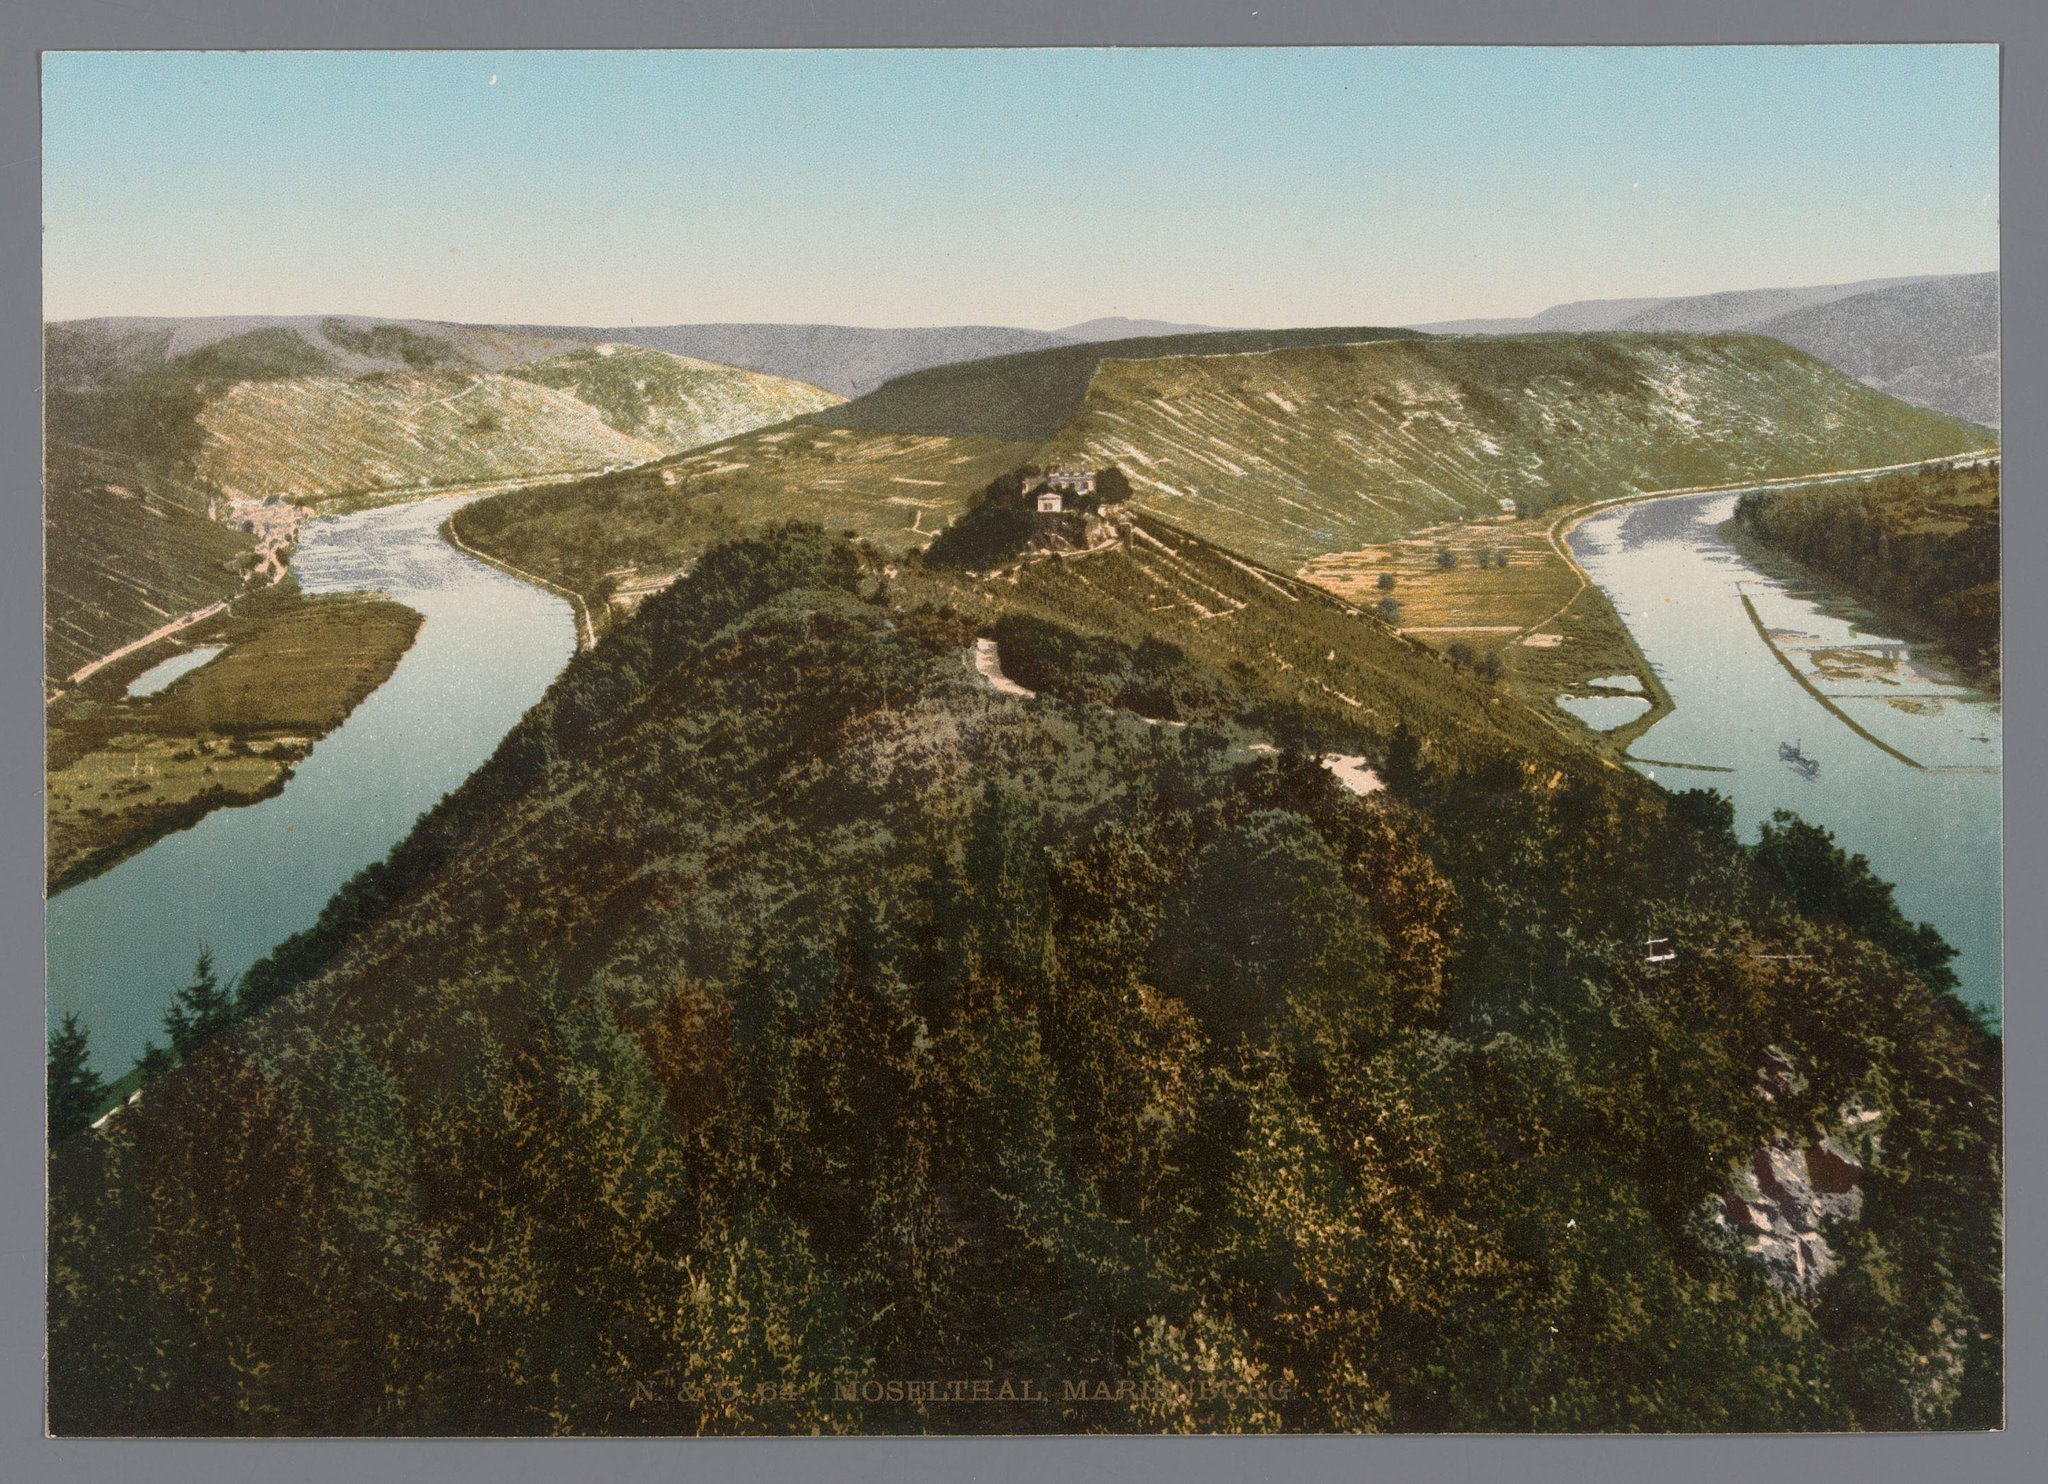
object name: photomechanical print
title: Moselthal, Marienburg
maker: Anonymous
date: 1890-1920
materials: paper, photographic process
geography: punderich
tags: river, cloisters ~ monastery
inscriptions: number: ‘64.’